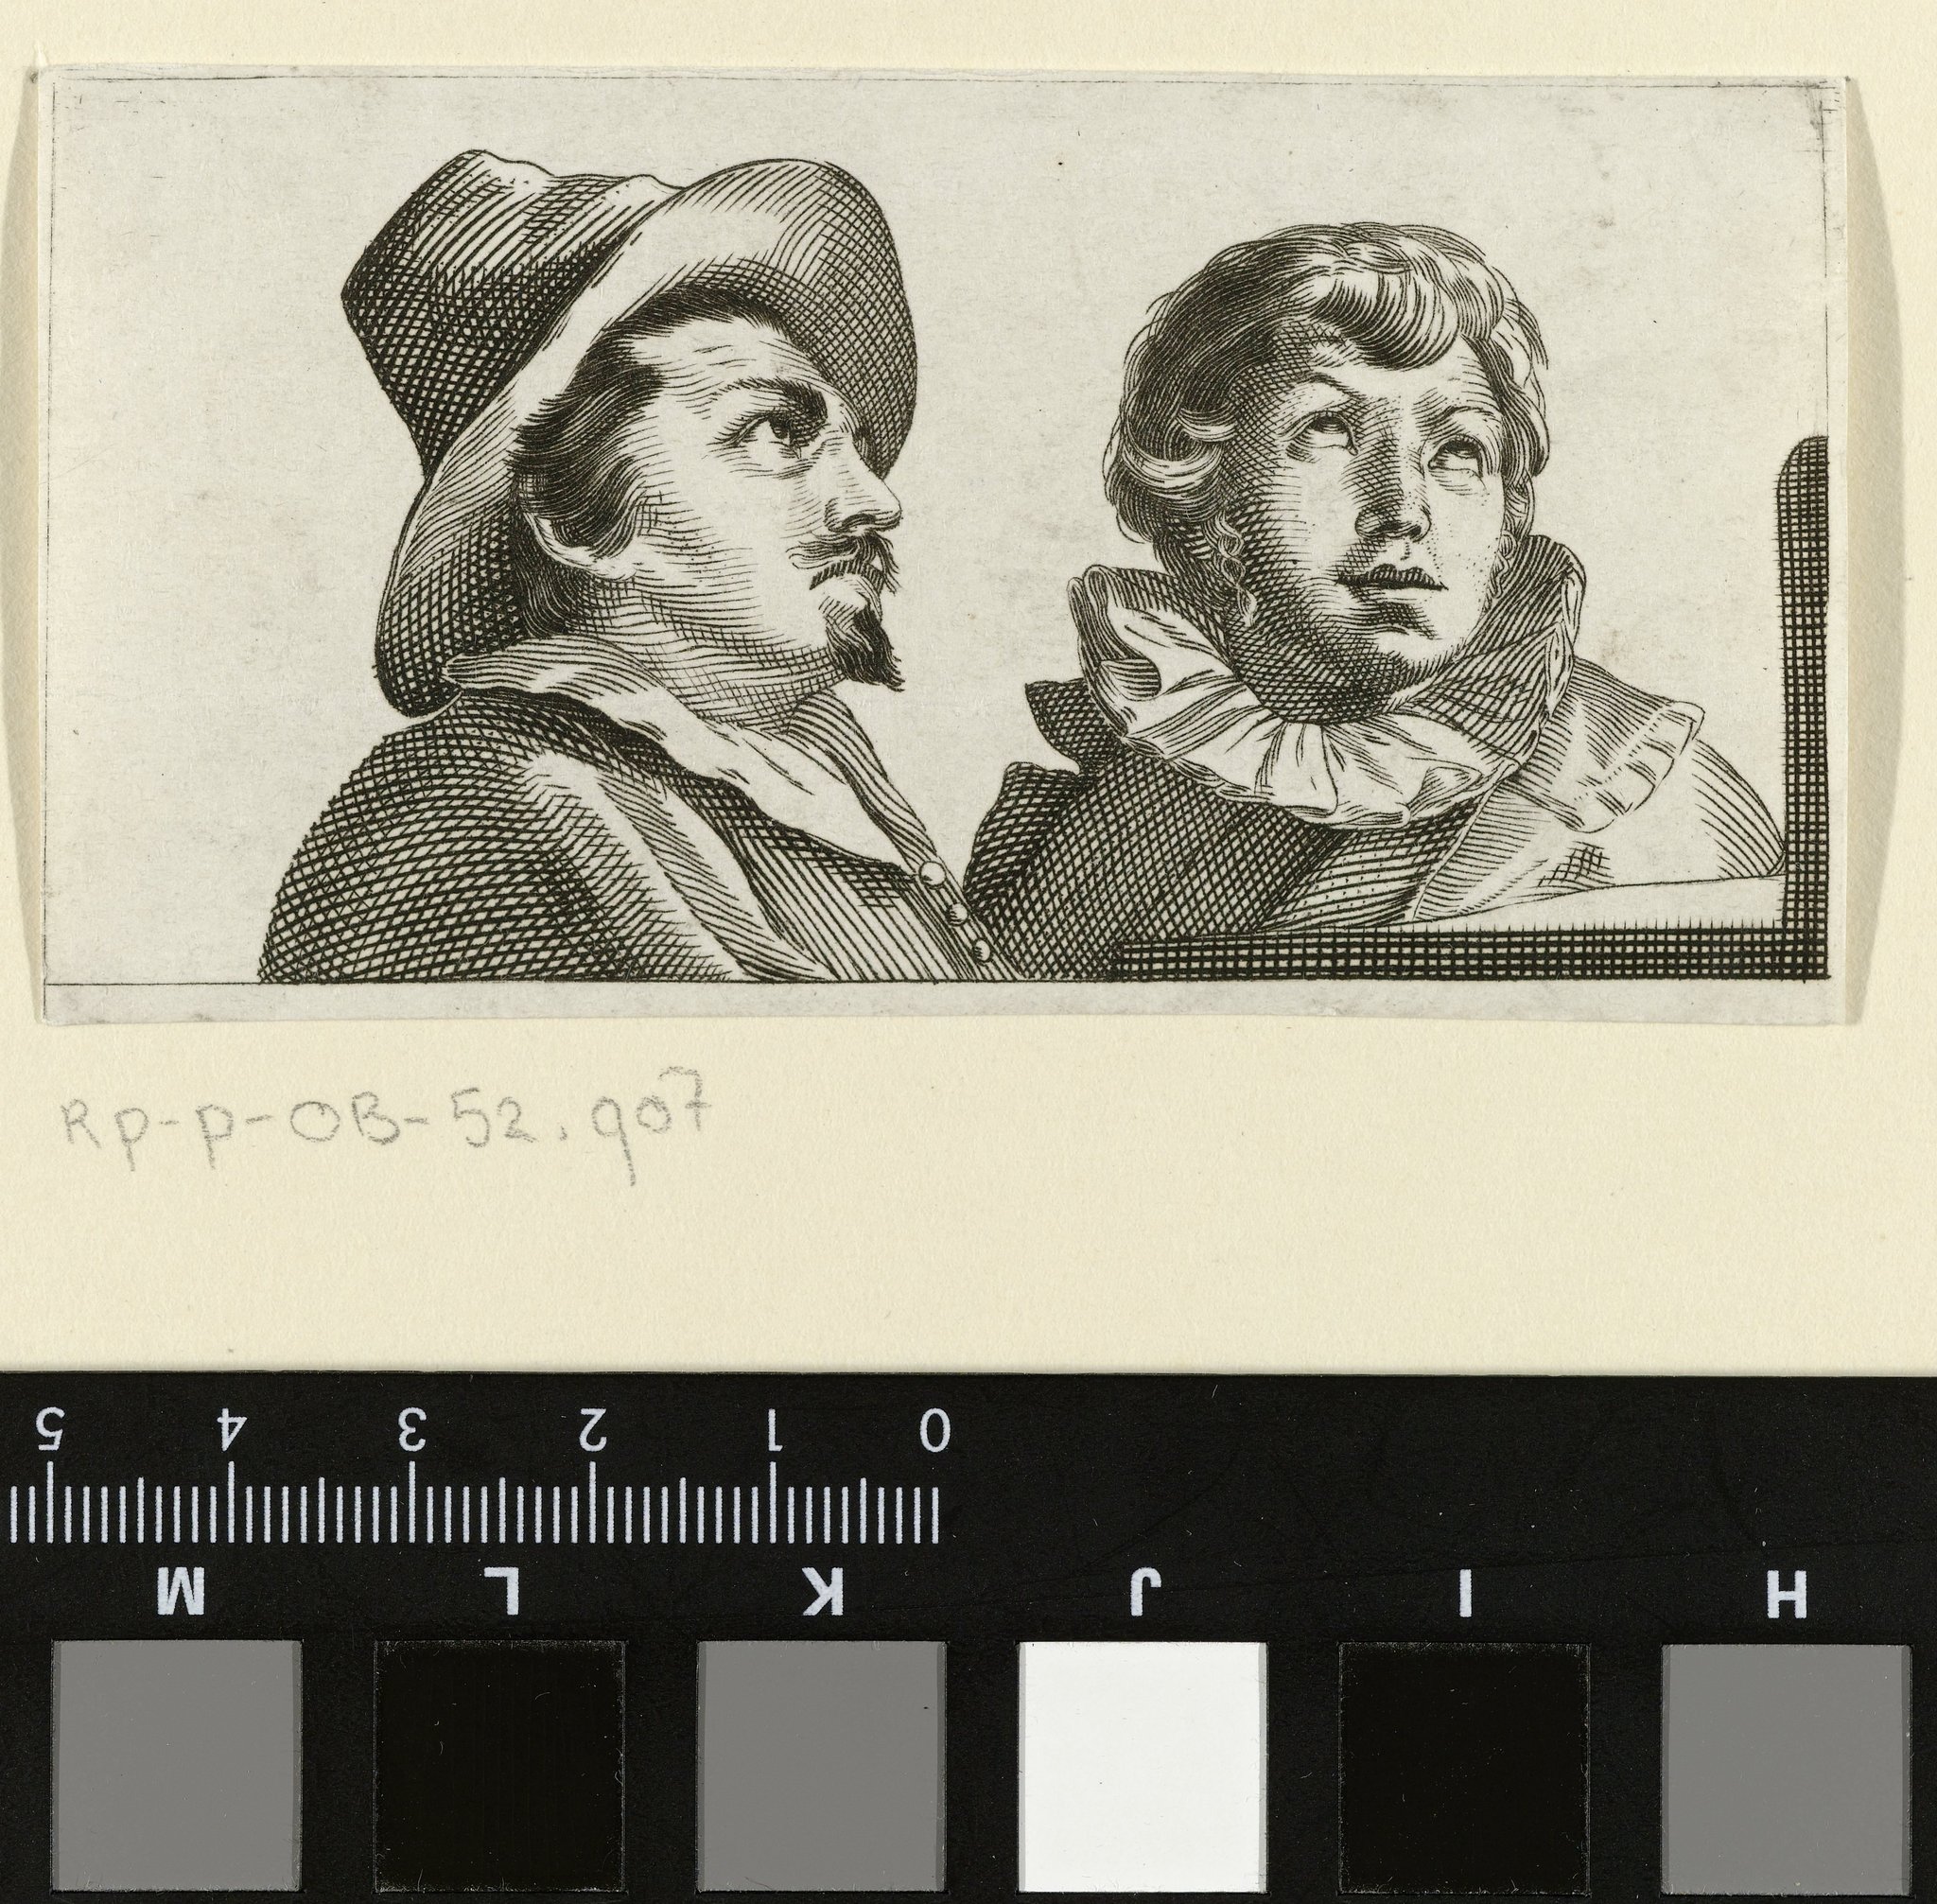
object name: print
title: Twee mannen die het beeld Hercules Farnese bekijken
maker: Anonymous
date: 1617-1667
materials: paper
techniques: engraving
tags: looking upwards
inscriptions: collector's mark: Lugt 2228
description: Twee mannen kijken op naar de sculptuur Hercules Farnese, die tot 1787 in het Palazzo Farnese te zien was.